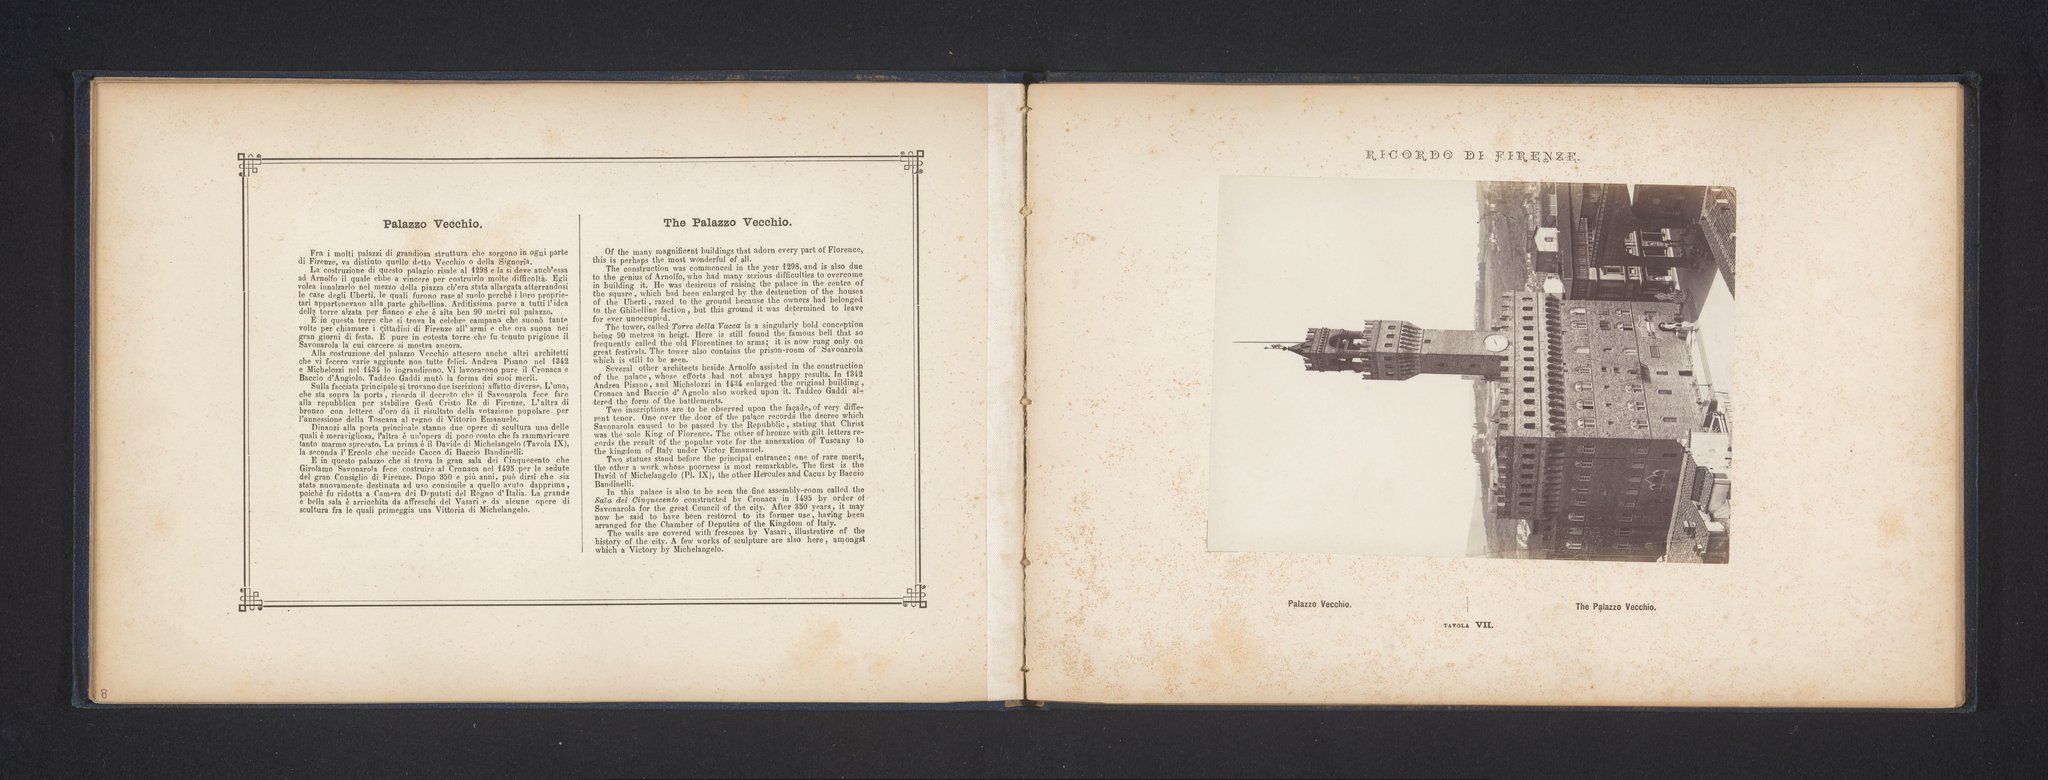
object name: photograph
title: Gezicht op het Palazzo Vecchio in Florence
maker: giacomo brogi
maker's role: fotograaf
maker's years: 1822-1881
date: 1861-1871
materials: photographic support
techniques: albumen print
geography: florence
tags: tower, clock tower ~ monumental adornment, palace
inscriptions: number: ‘Tavola VII.’